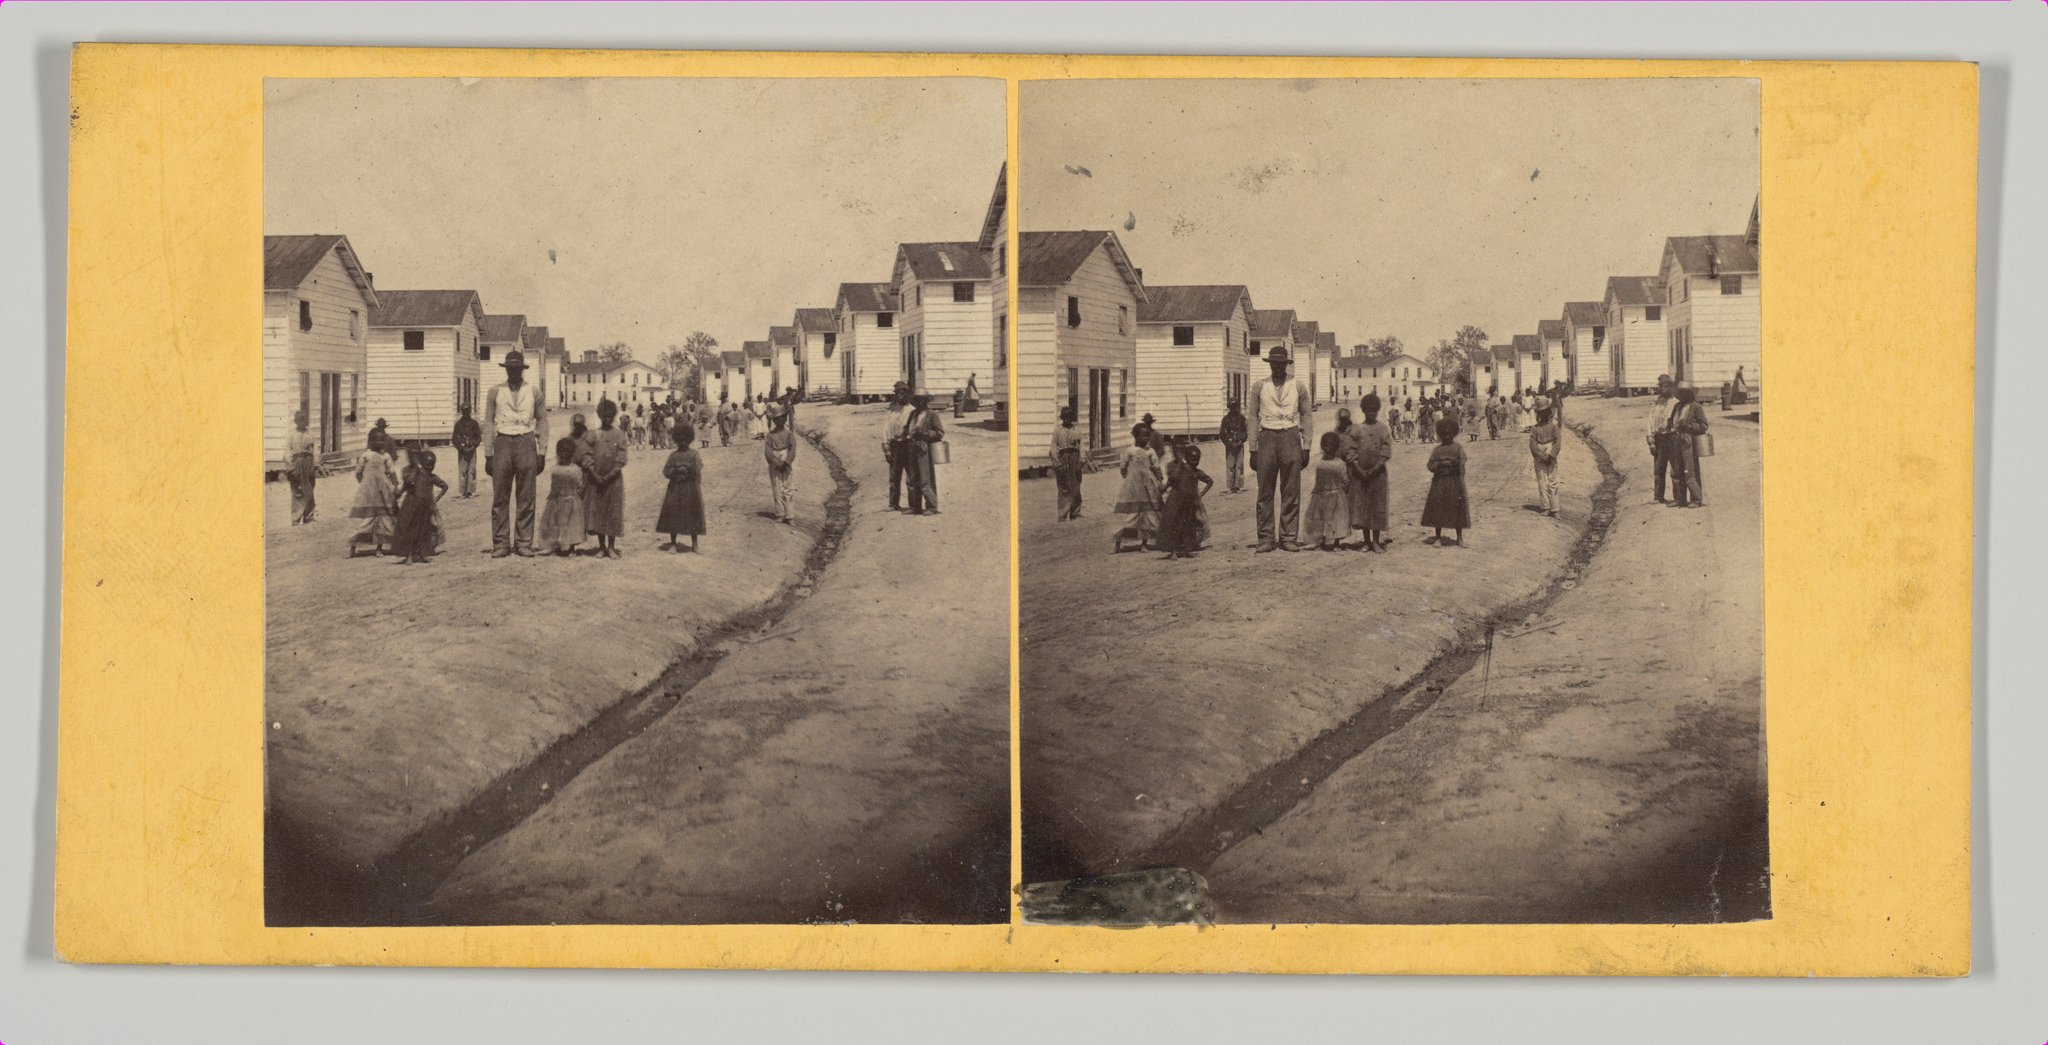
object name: stereograph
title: Freedman’s Village, Arlington, VA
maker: Anonymous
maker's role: artist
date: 1863-1864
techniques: albumen silver print, glass negative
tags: american civil war